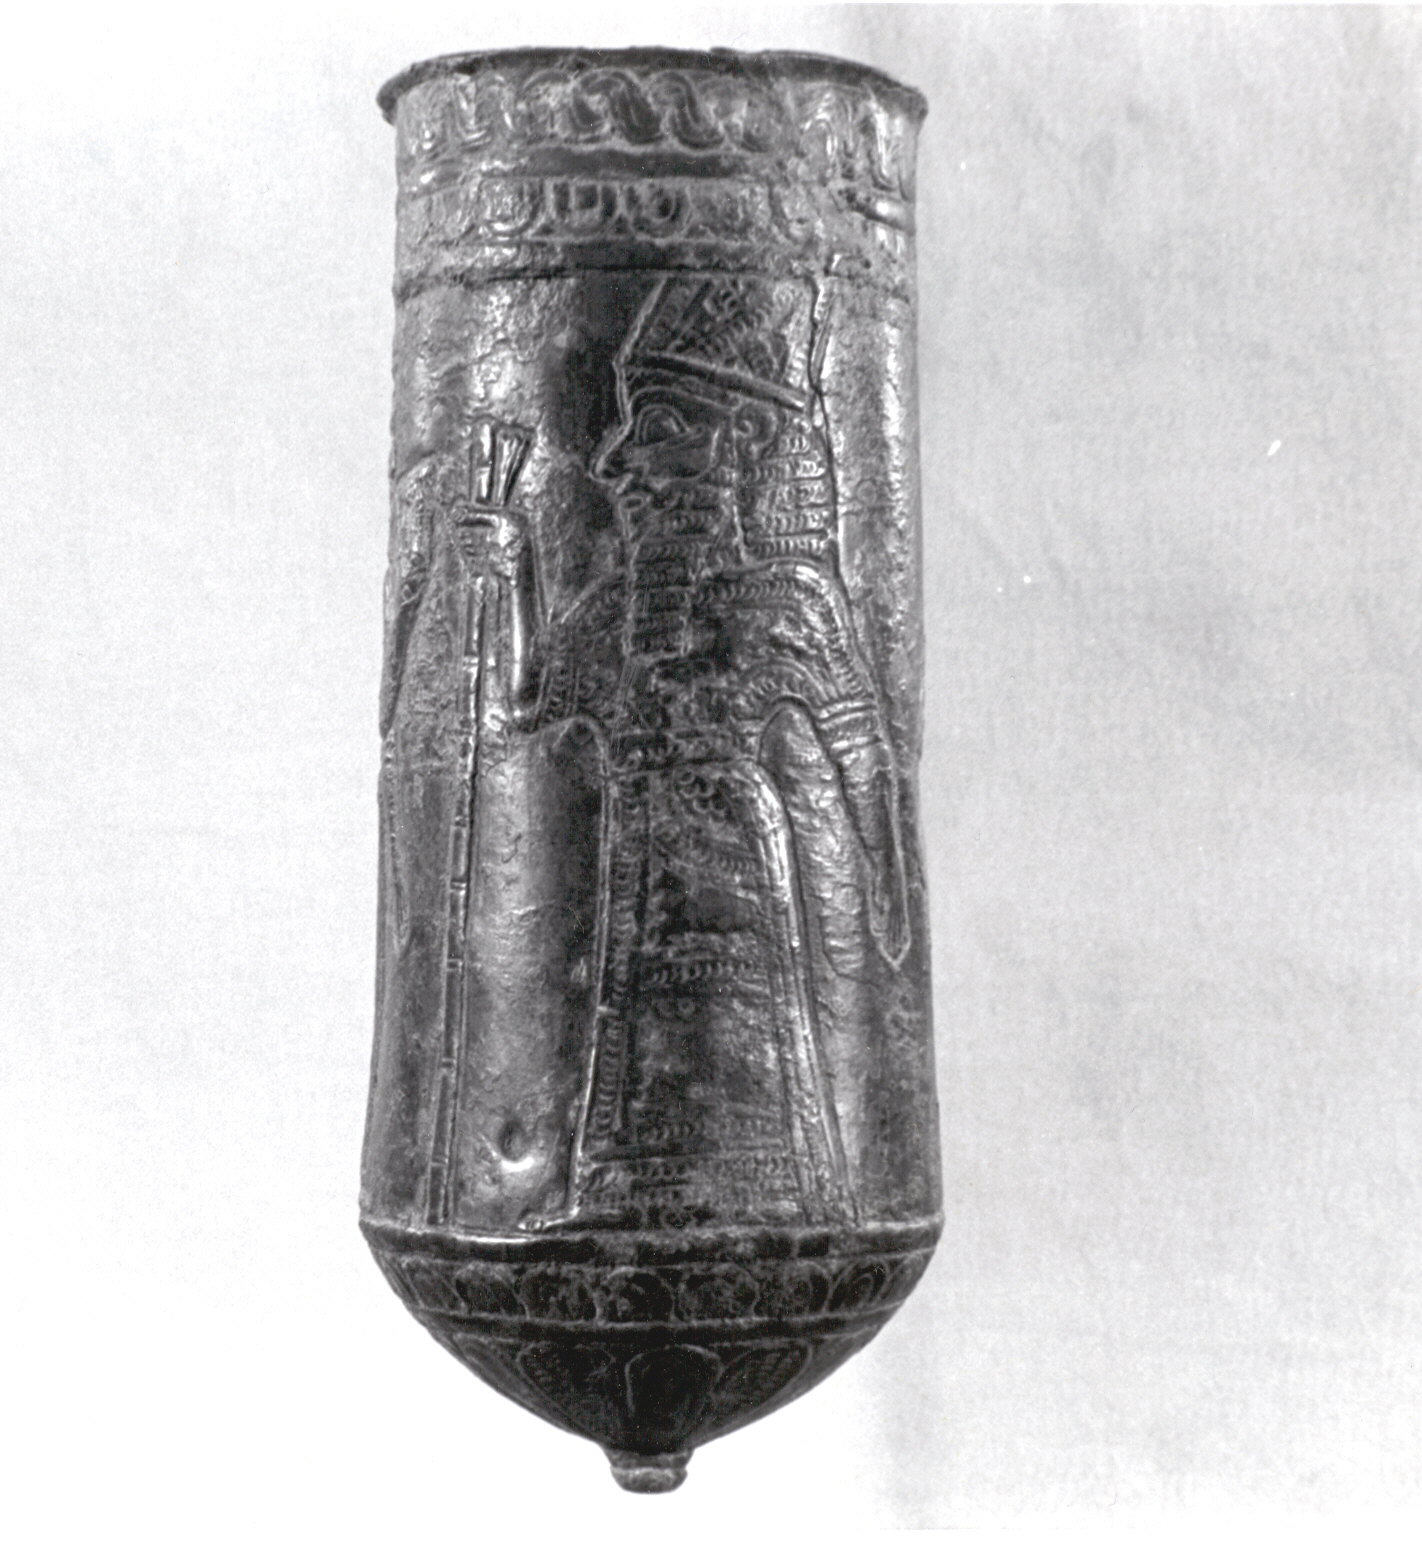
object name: beaker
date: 1000-801 BCE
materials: bronze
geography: western iran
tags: men